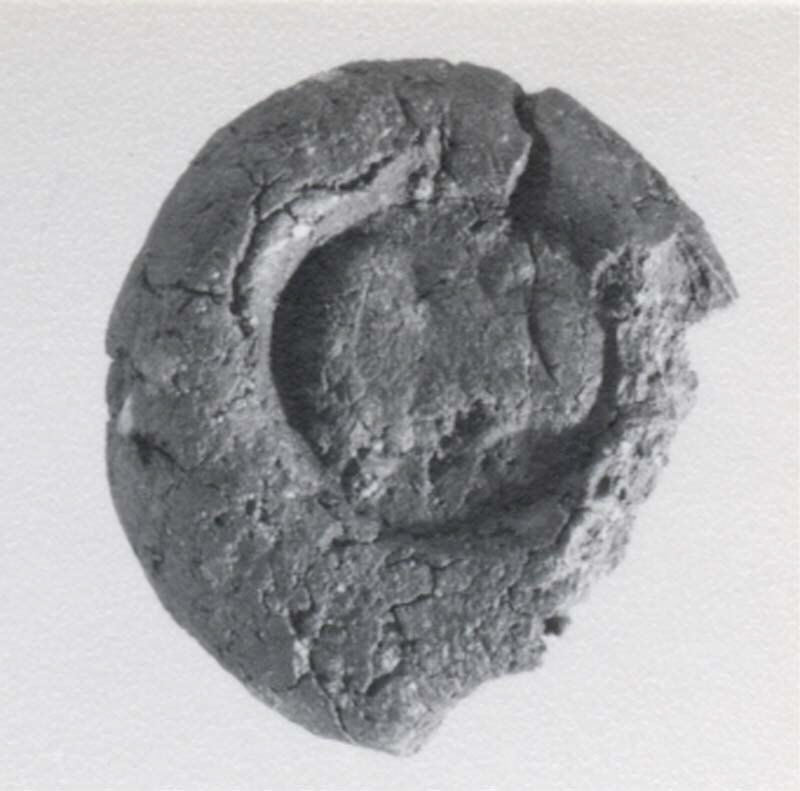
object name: sealing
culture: sasanian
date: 601-700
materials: clay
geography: iran